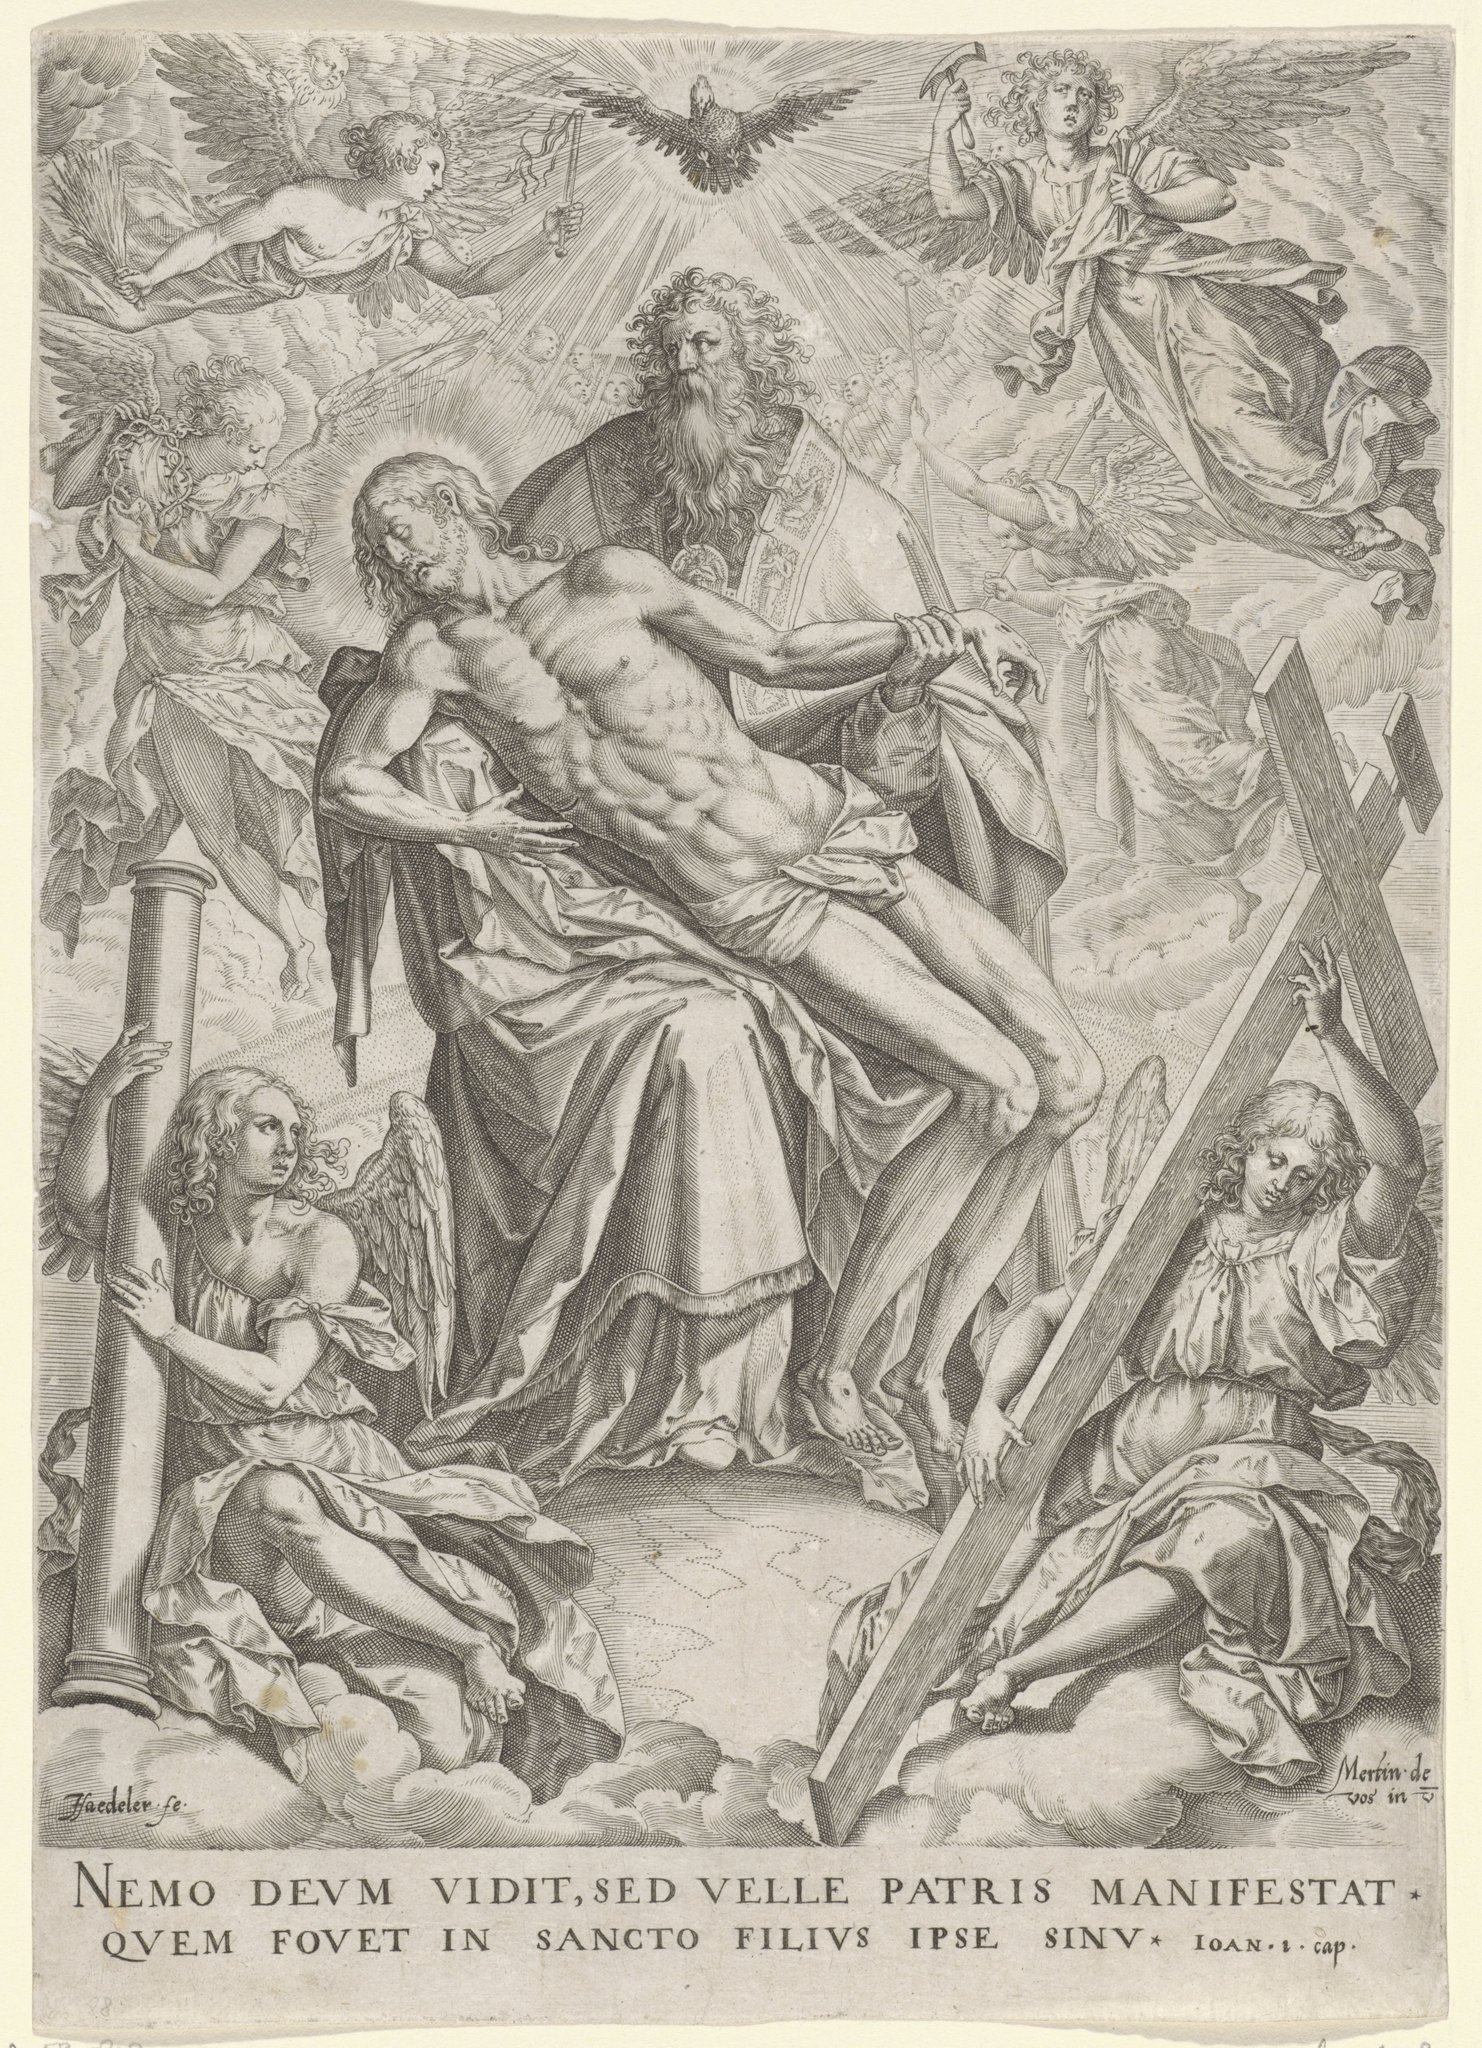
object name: print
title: De heilige Drieëenheid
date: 1560-1600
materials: paper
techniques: engraving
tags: father and holy ghost holding the crucified christ (~ trinity), virtues (holding instruments of the passion) ~ hierarchy of angels, 'arma christi'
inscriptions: collector's mark: Lugt 2228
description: God de Vader met het lichaam van Christus op zijn schoot. God staat op een wereldbol in de wolken. Boven zijn hoofd de Heilige Geest als duif. Omgeven door engelen met de passiewerktuigen.